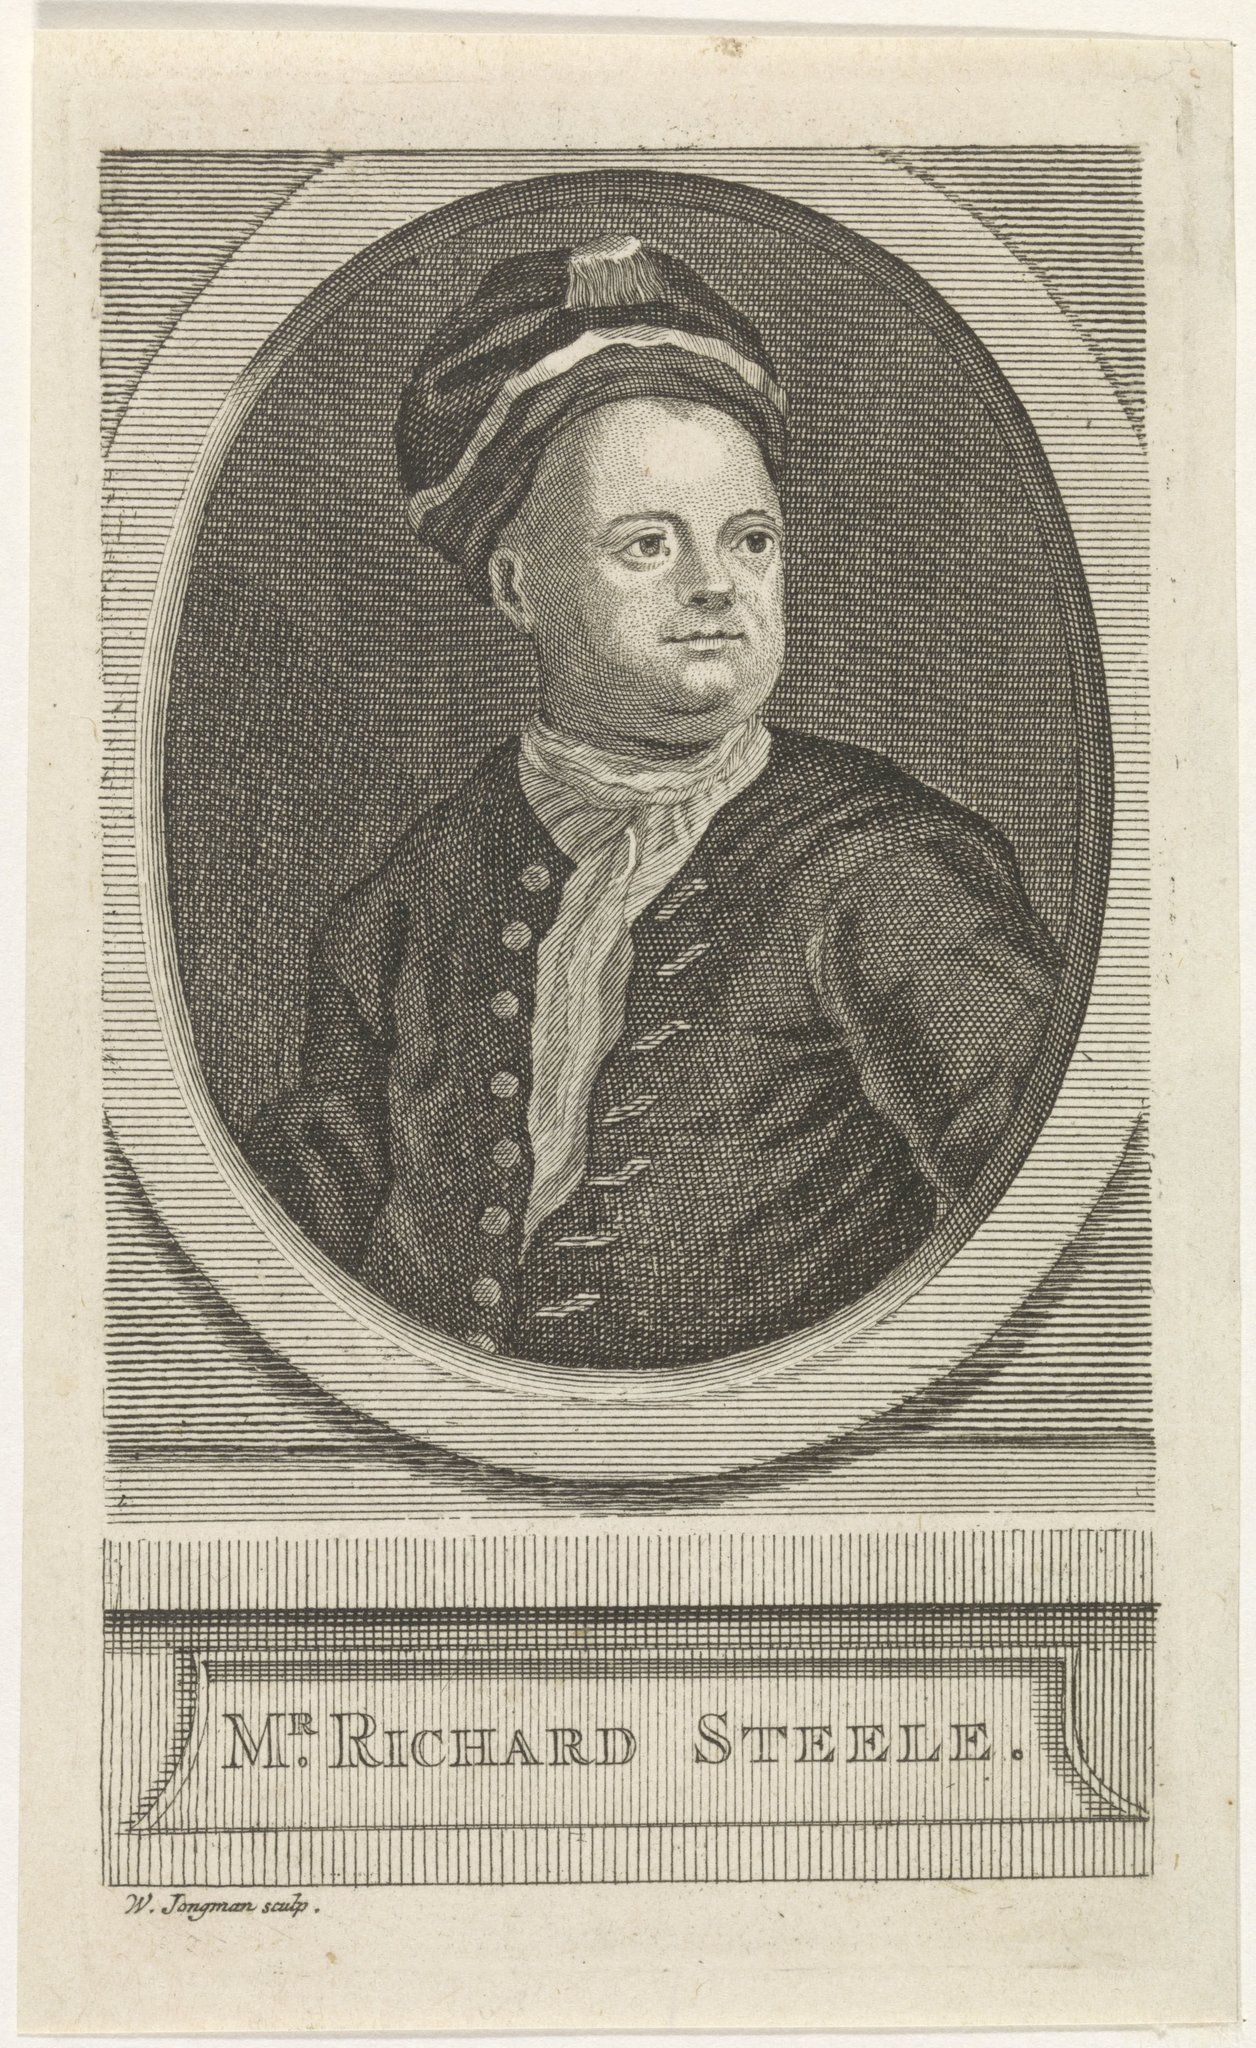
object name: print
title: Portret van Richard Steele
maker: wouter jongman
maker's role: print maker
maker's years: -1753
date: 1712-1744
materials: paper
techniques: engraving, etching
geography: amsterdam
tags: schrijver, journalist, richard steele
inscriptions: collector's mark: Lugt 2228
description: Busteportret van Richard Steele, met hoofddeksel. Het portret is gevat in een ovale omlijsting. In een kader de naam van de geportretteerde.